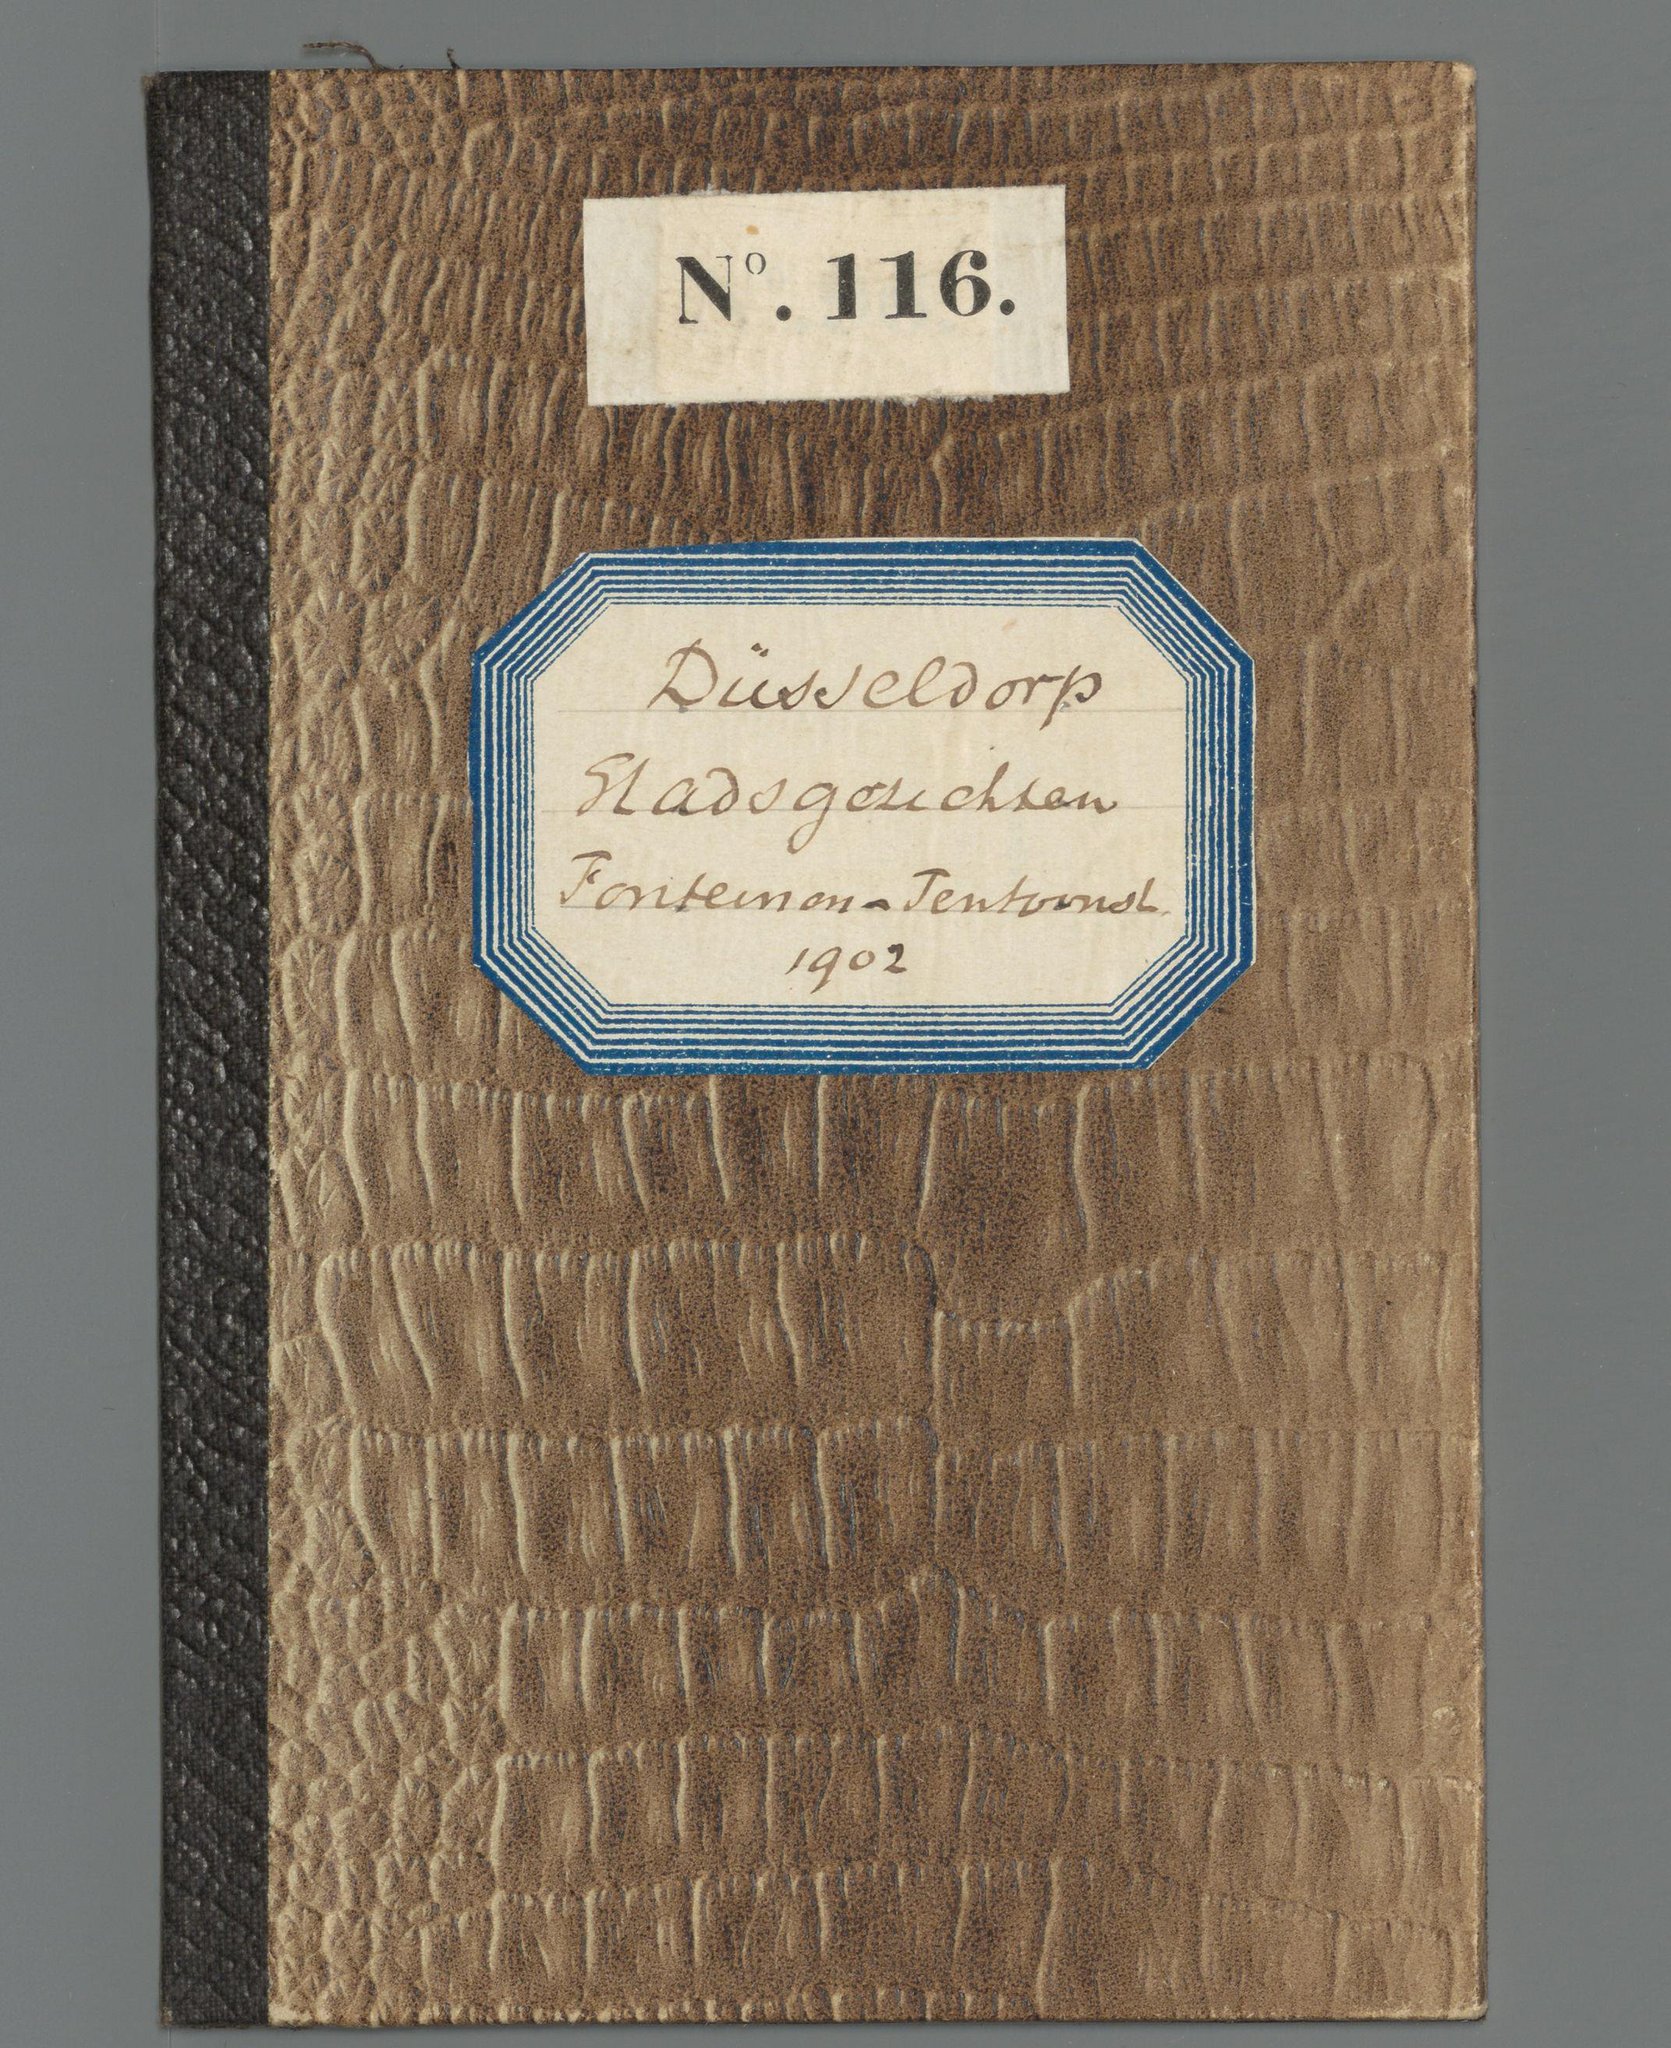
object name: wrapper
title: Düsseldorp. Stadsgezichten. Fonteinen-Tentoonst. 1902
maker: Anonymous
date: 1900-1950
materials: cardboard, paper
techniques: lithograph, writing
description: In de omslag zit een kaart ingestoken met daarop een korte beschrijving van de inhoud.